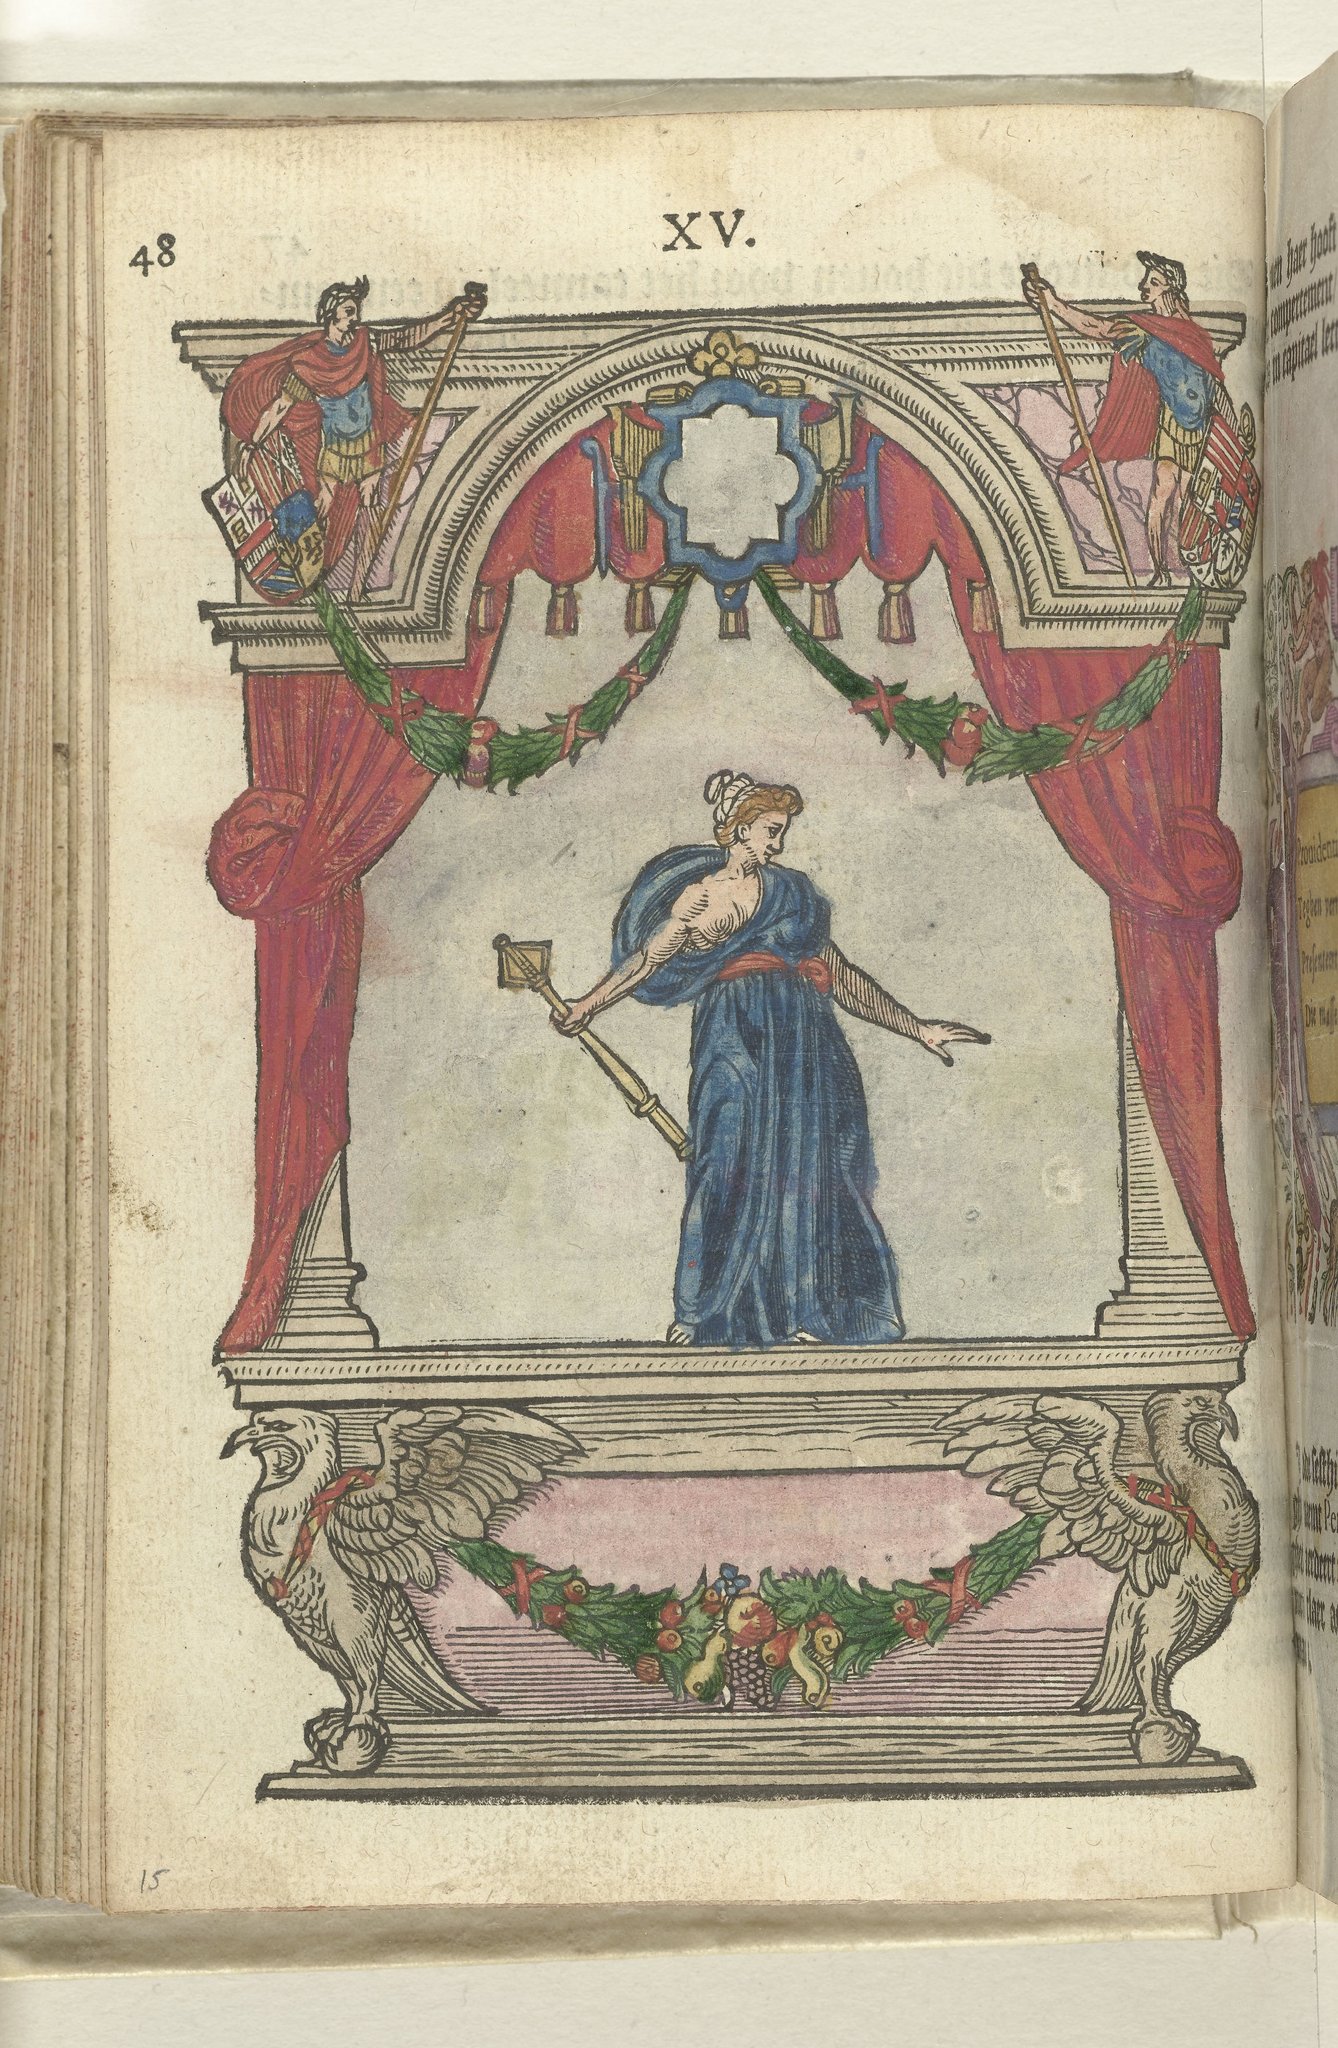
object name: print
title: Toneel met personificatie van de Voorzienigheid (Providentia), 1578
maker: antoni van leest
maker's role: print maker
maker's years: 1545-1592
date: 1578-1579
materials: paper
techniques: hand coloring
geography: antwerp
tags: vienna, matthias van oostenrijk (rooms-duits keizer), group of actors, troupe; actors on the stage, triumphal entry and public reception, pageant, 'entrée solennelle', 'joyeuse entrée', forethought, deliberation; 'previdenza', 'providenza' (ripa), brussels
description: Illustratie in: J.B. Houwaert, Sommare beschrijvinghe vade triumphelijcke Incomst van den doorluchtighen ende hooghgheboren /Aerts-hertoge Matthias binnen die Prinelijcke stadt van Brussele, in 't iaer ons Heeren 1578 den XVIII dach Januarij... Gheinventeert ende ghecomponeert deur Jean Baptista Houwaert, Christoffel Plantijn, Antwerpen 1579. Boek in de Rijksmuseum Research Library met signatuur: 327 K 2.